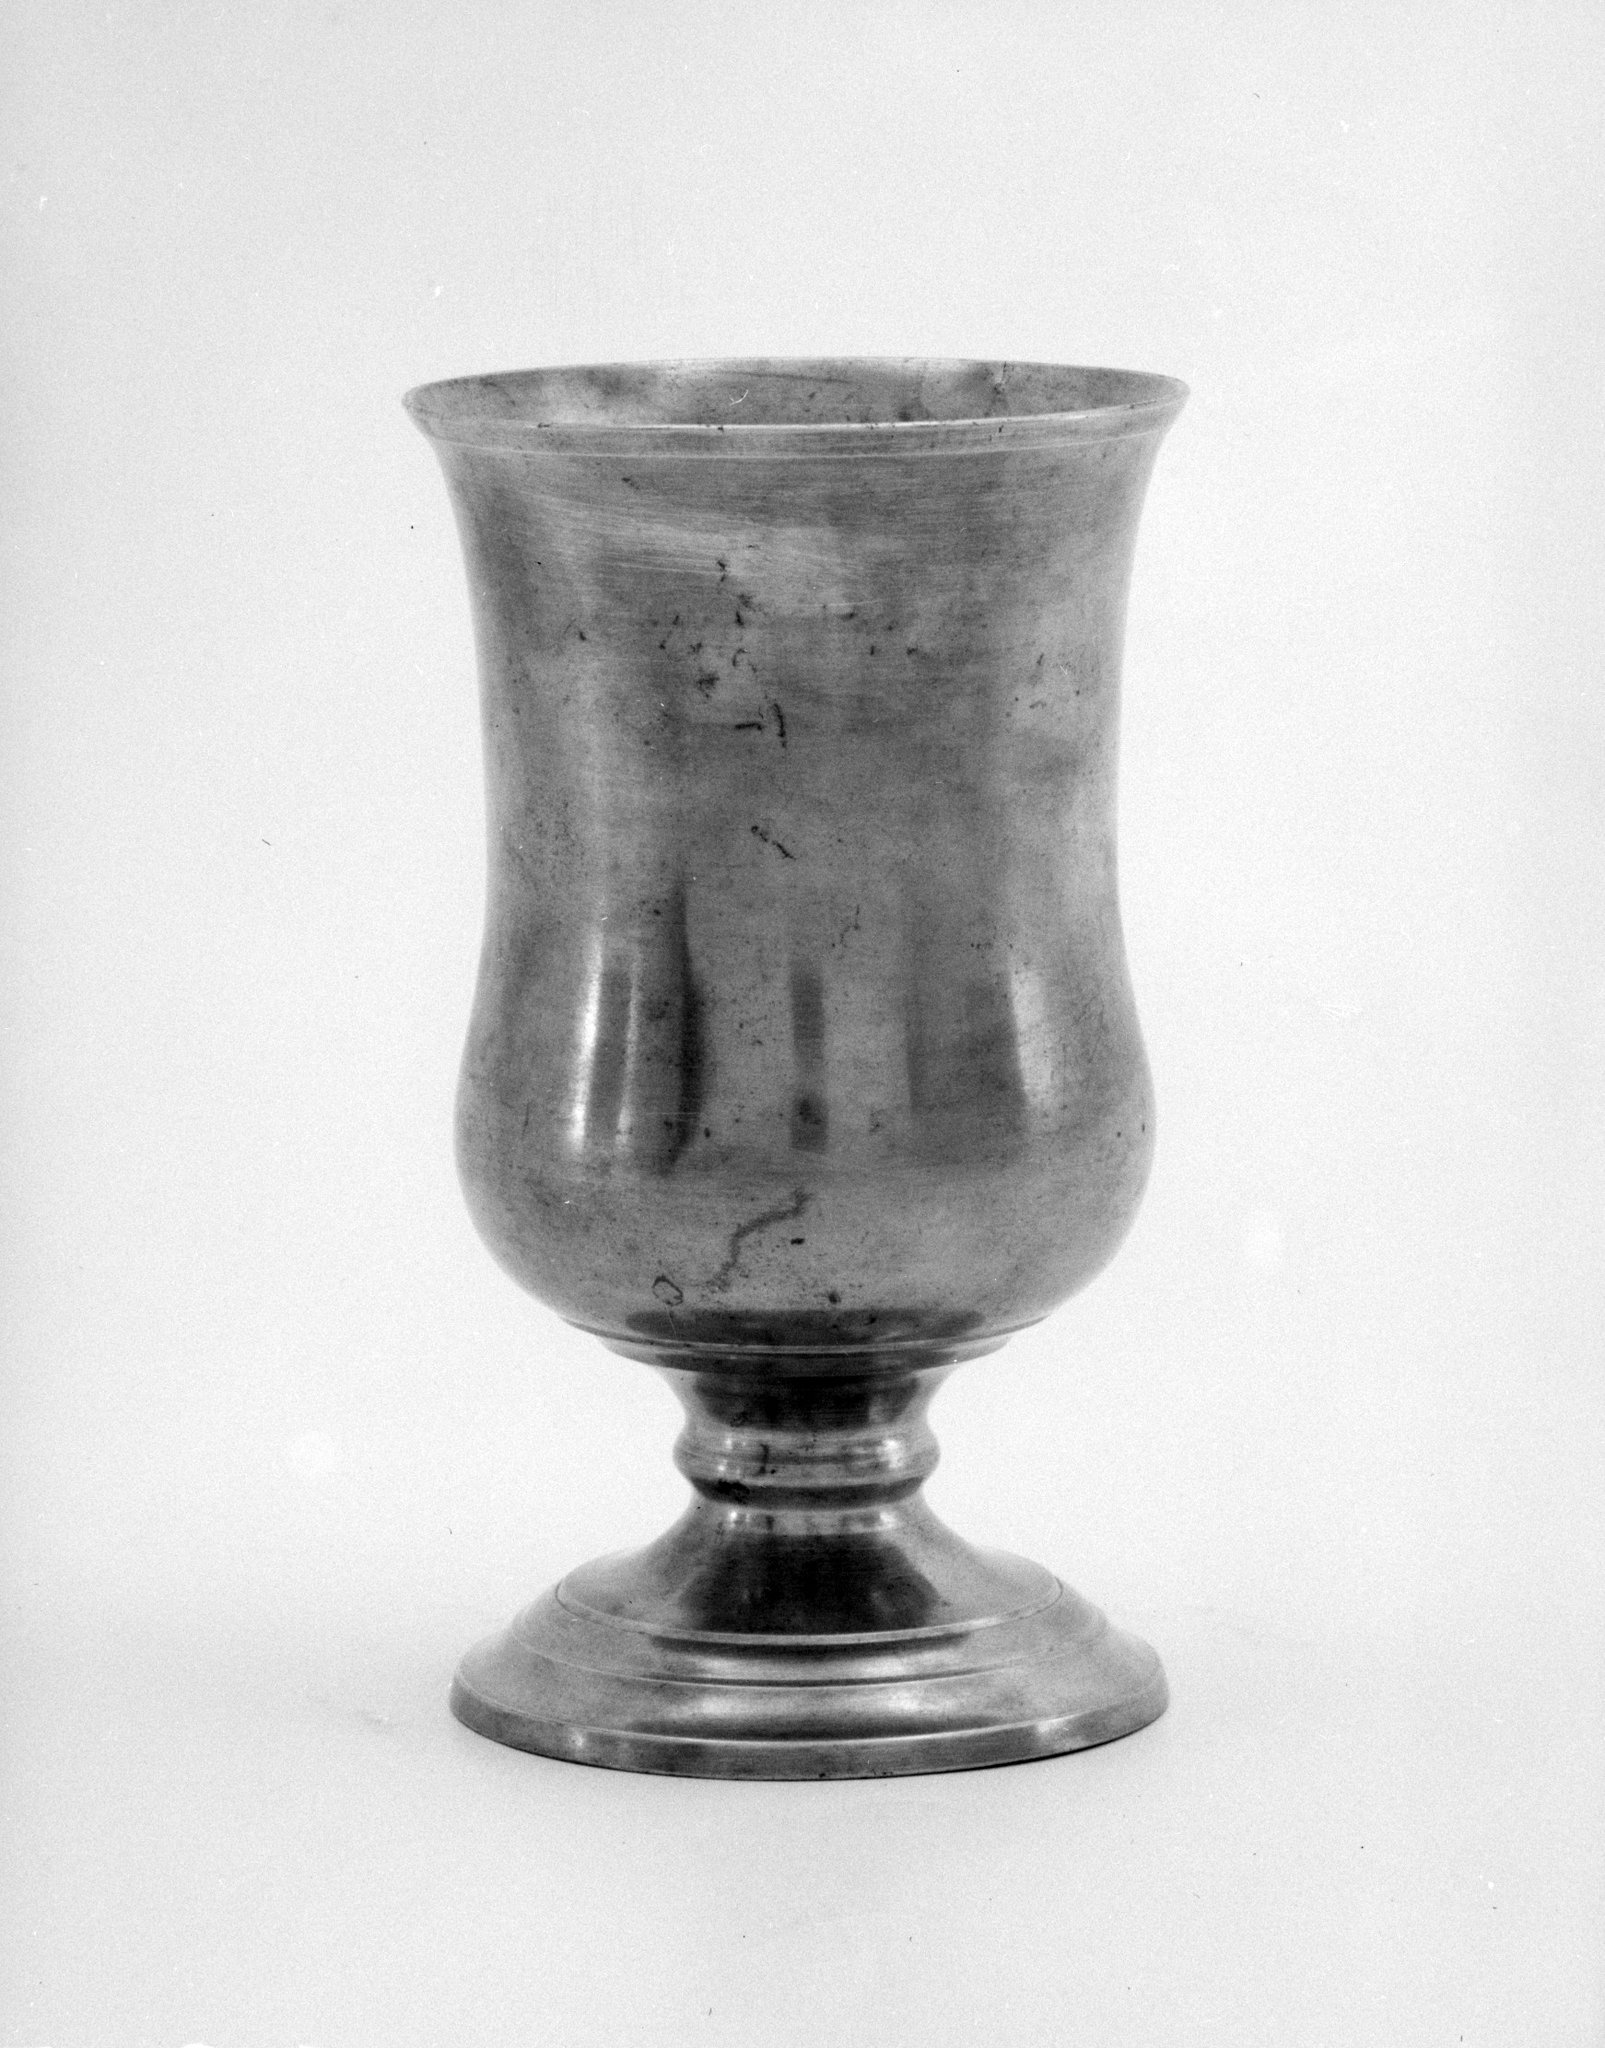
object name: chalice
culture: american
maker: israel trask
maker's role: maker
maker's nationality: american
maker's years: 1786-1867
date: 1813-1856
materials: pewter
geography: united states